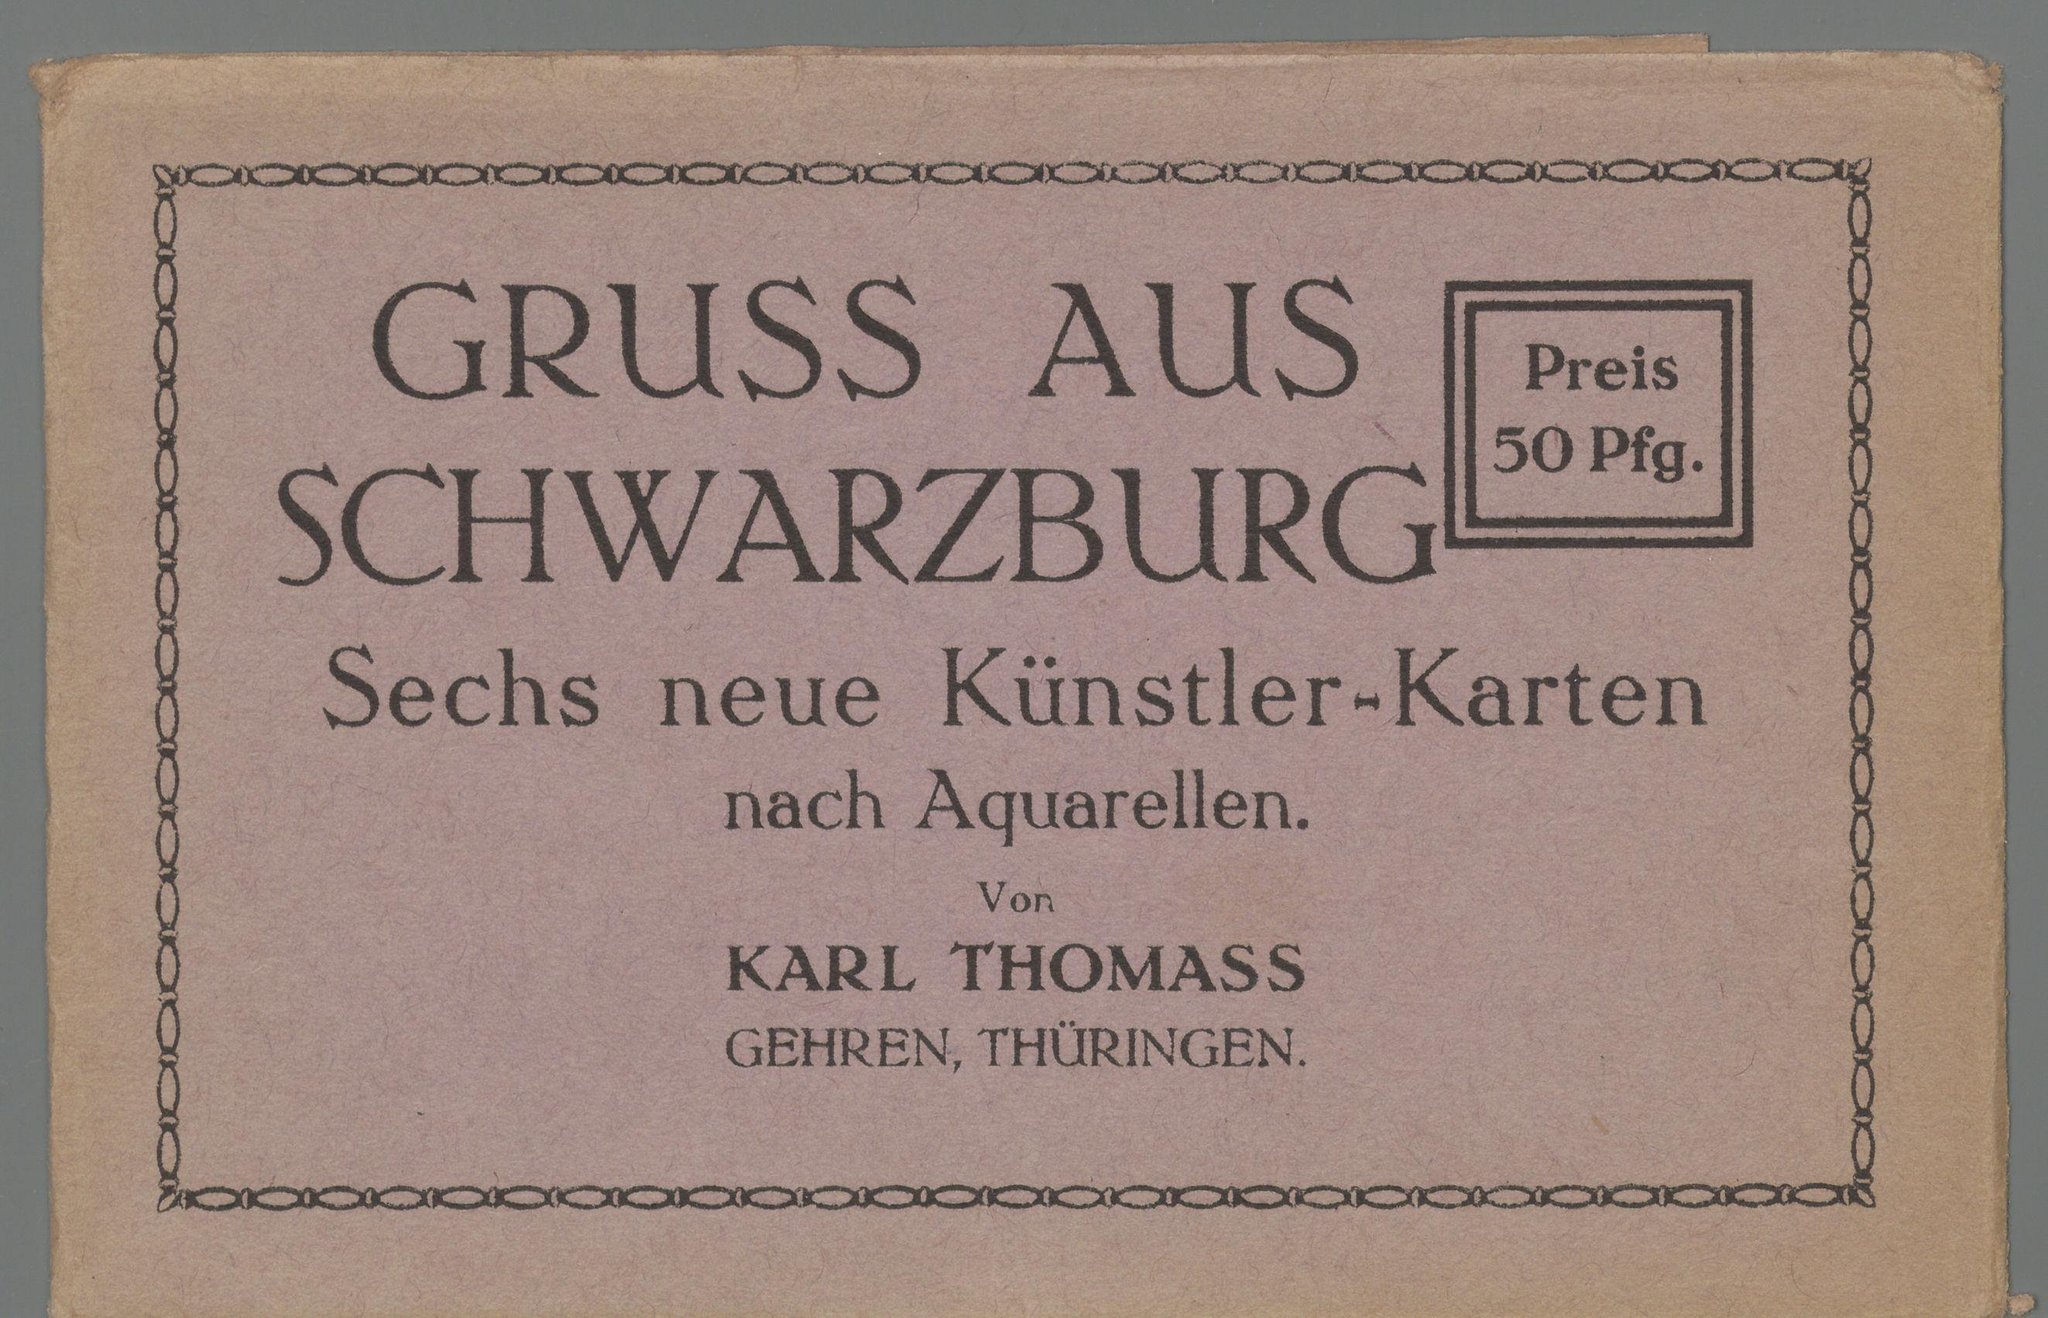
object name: wrapper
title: Omslag voor zes prentbriefkaarten met stadsgezichten uit Schwarzburg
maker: Anonymous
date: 1905-1930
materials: paper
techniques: lithograph